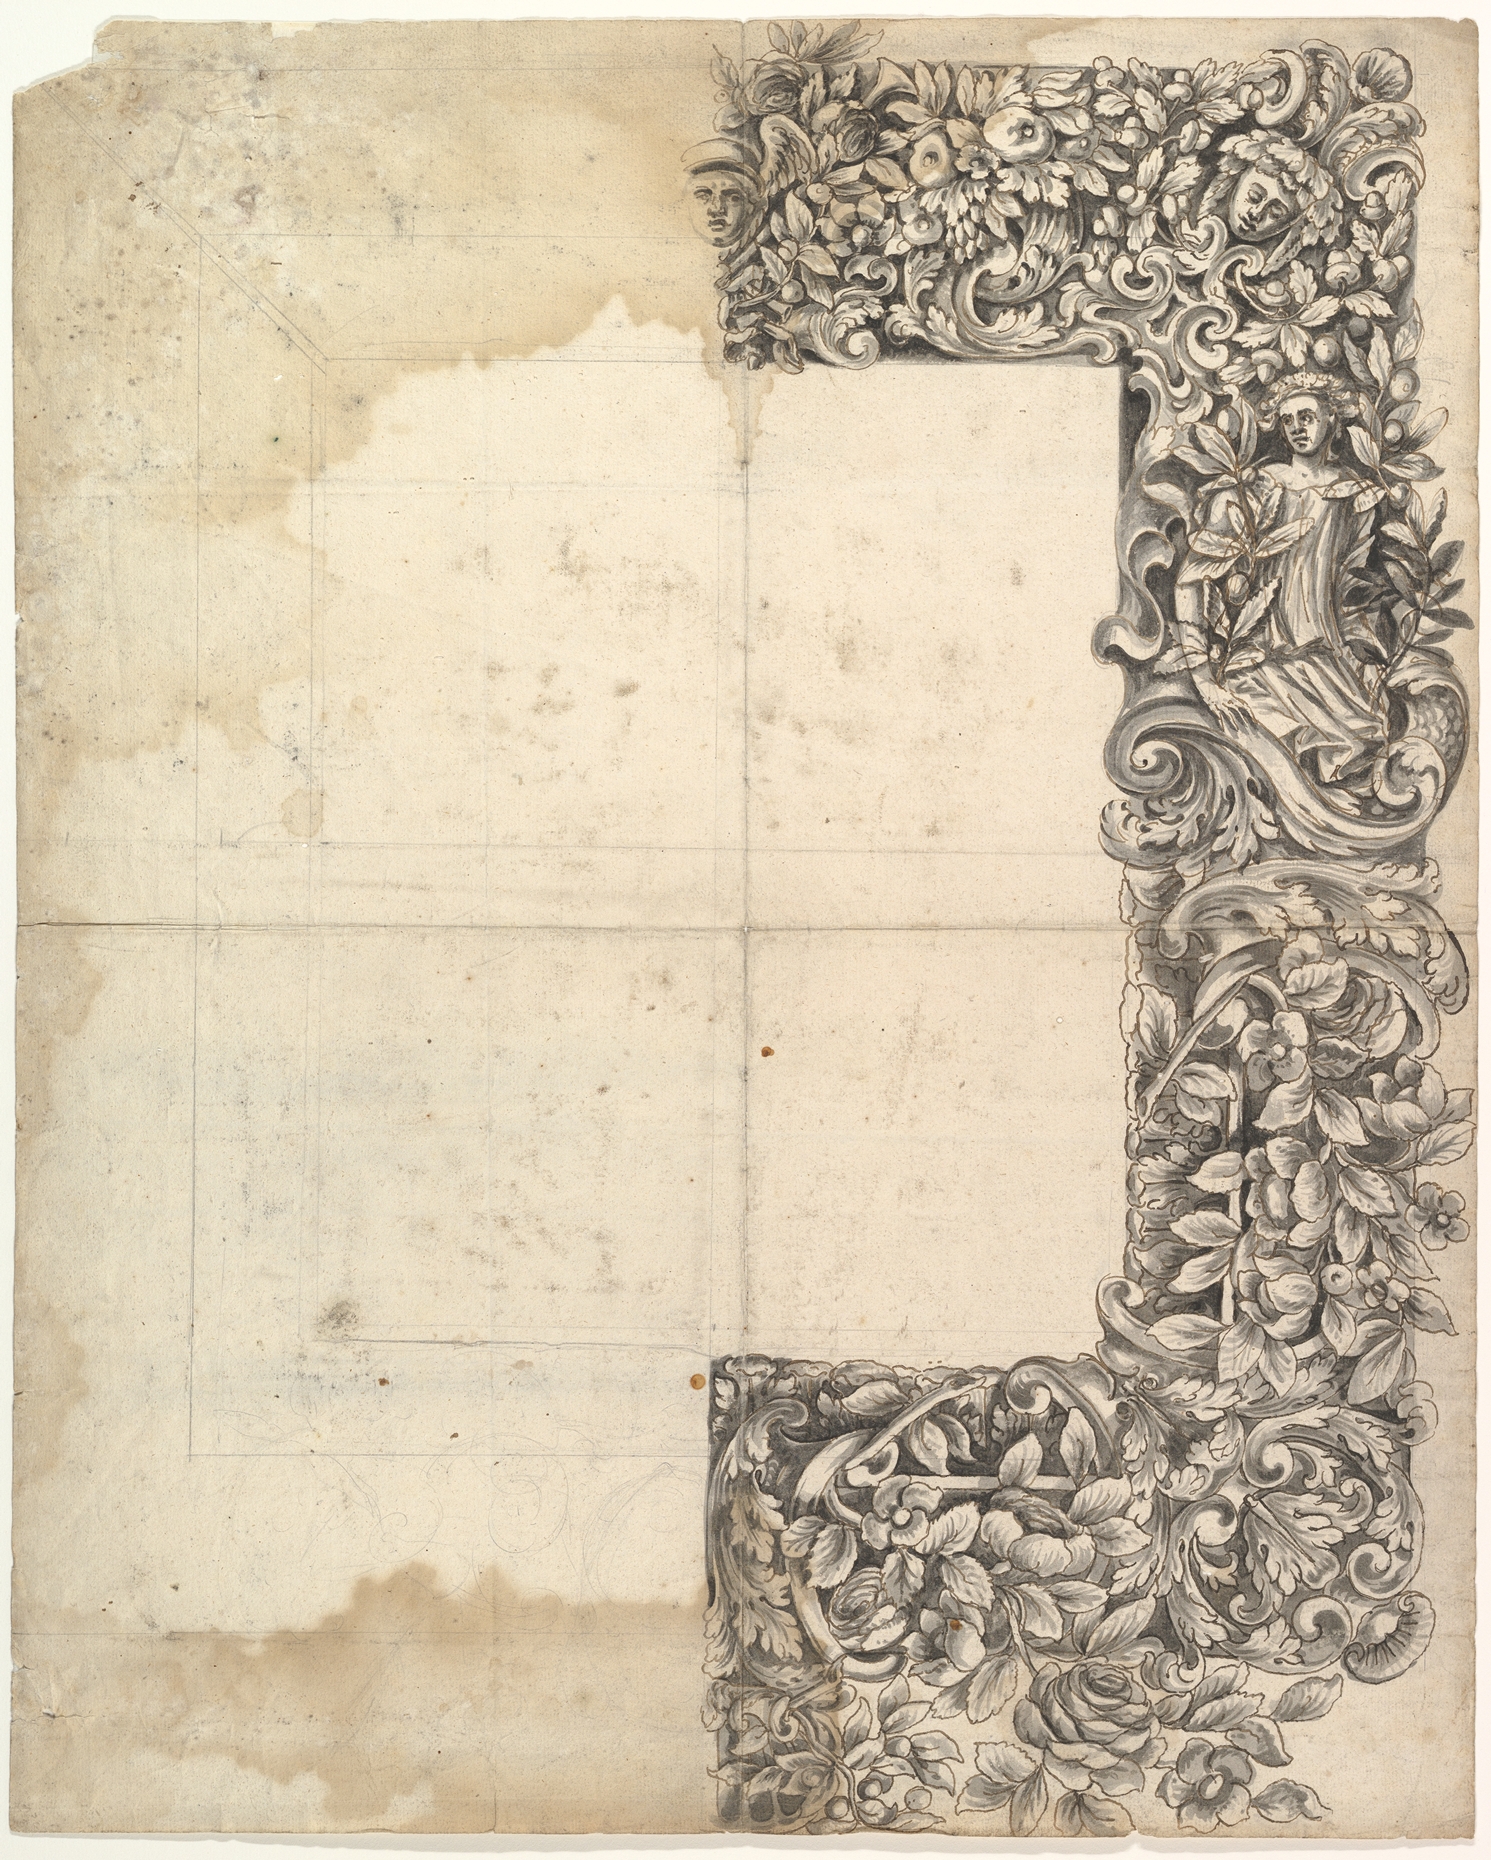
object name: drawing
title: Design for a Carved Mirror Frame (right side only)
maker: anonymous, british, 17th century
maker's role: artist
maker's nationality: british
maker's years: 1600-1700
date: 1675-1685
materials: ink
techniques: brush, pen, wash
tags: faces,flowers,leaves